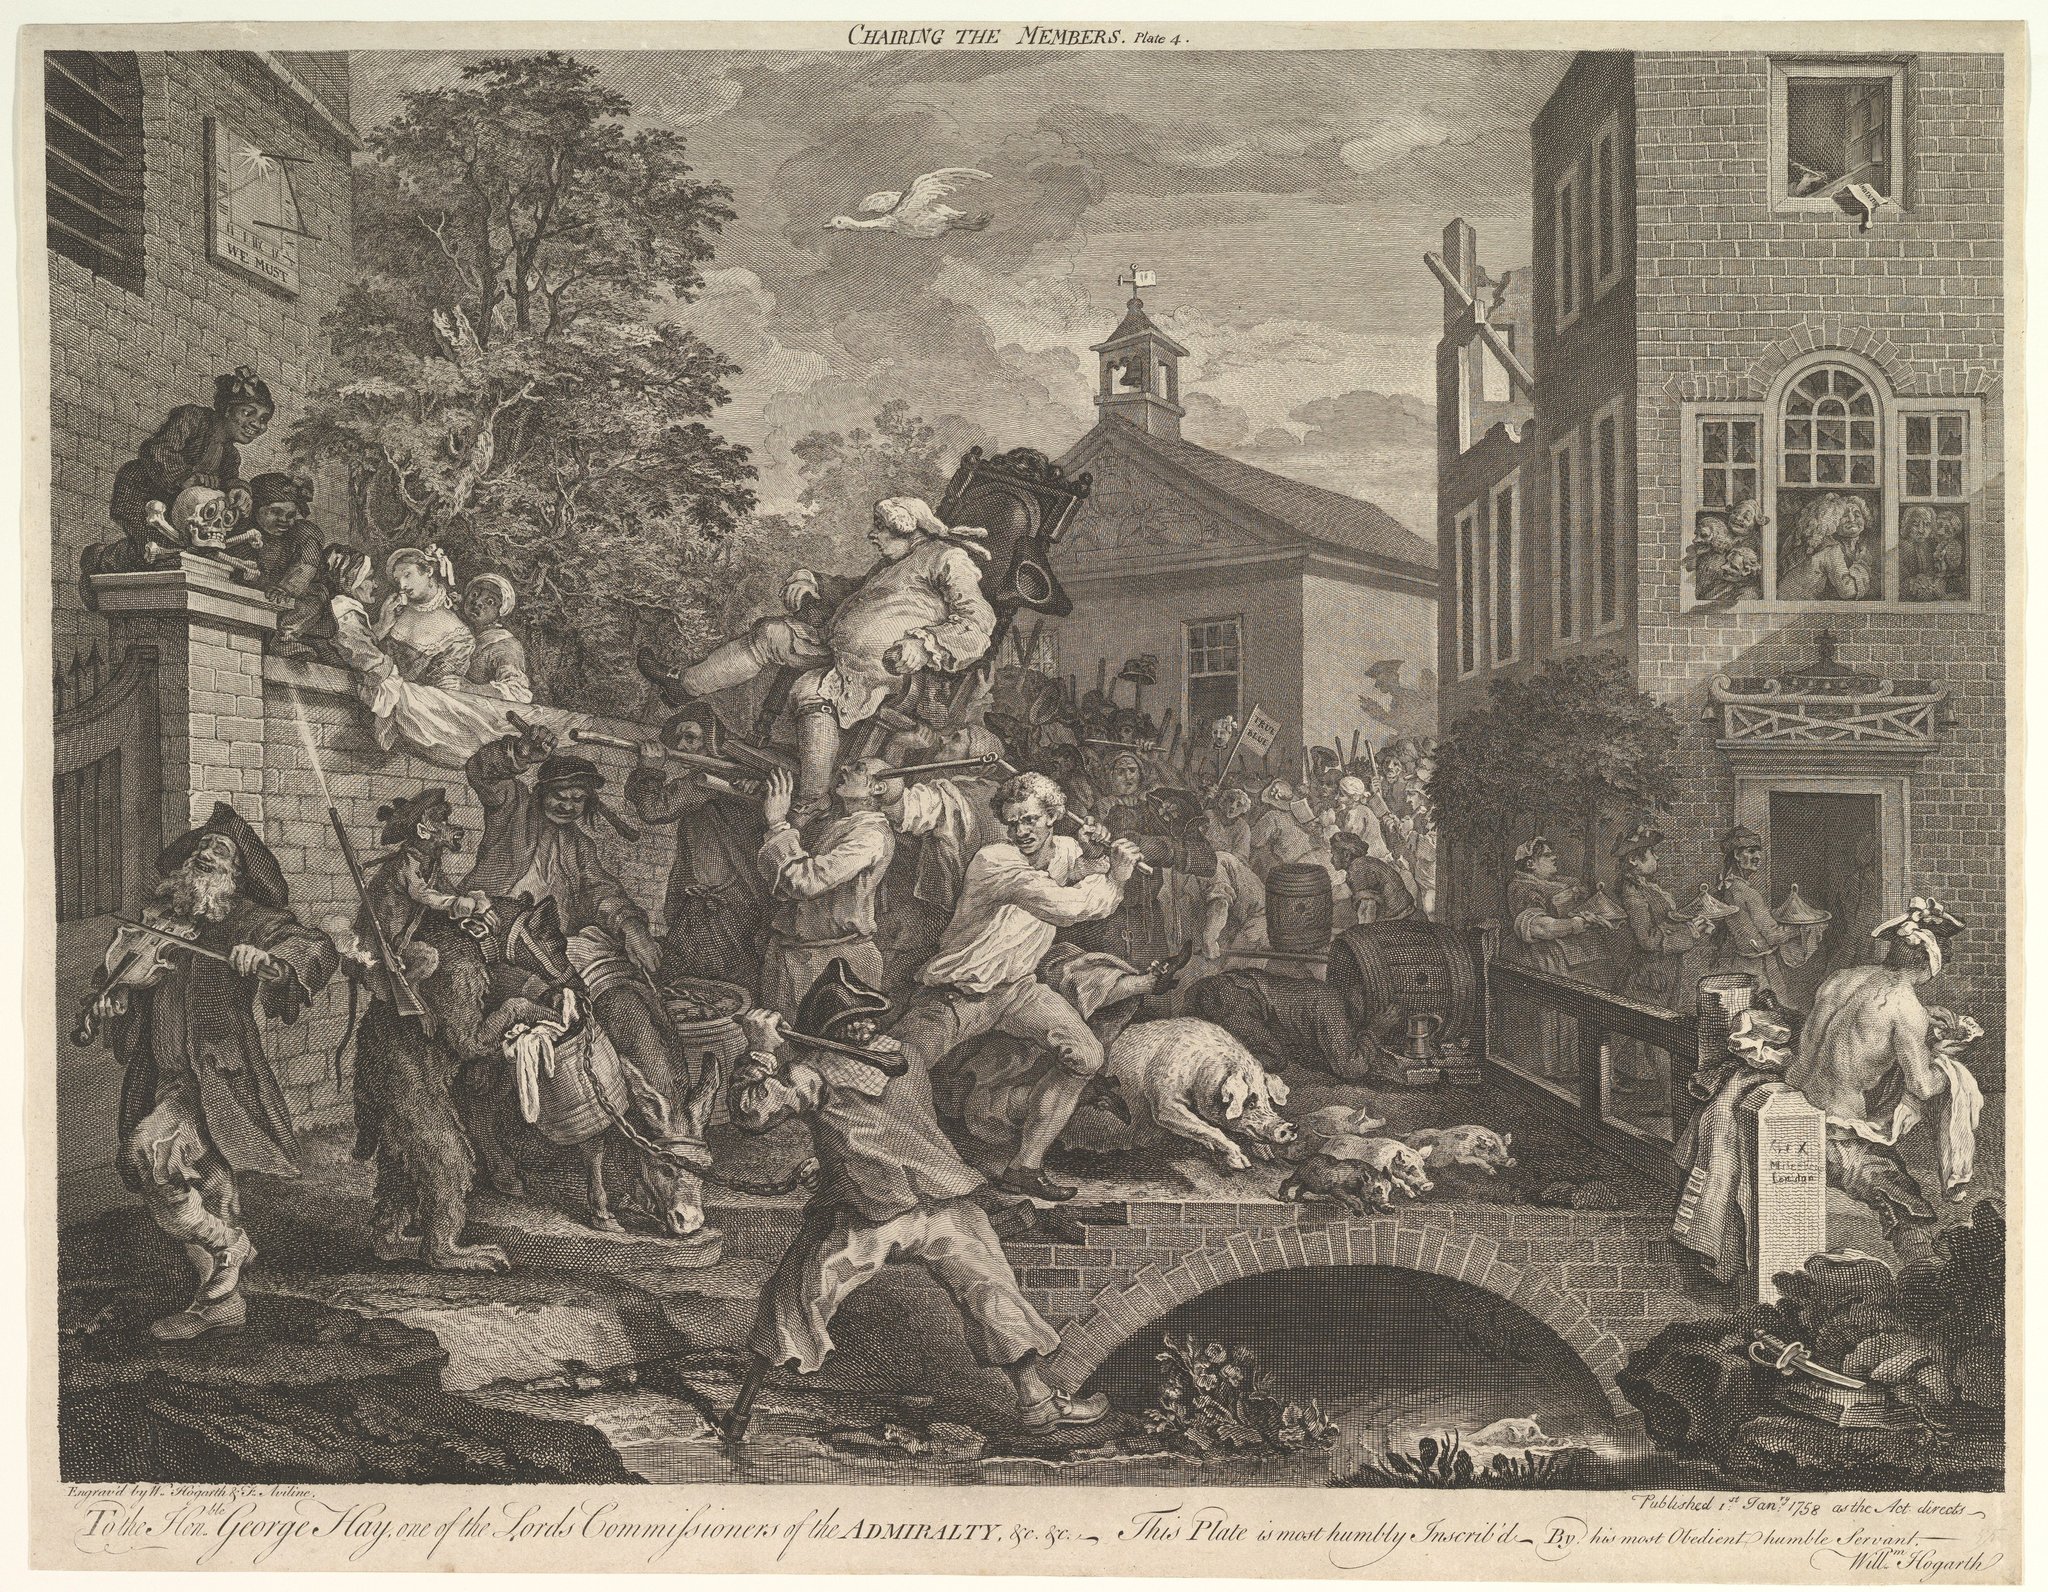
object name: print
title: Chairing the Members, Plate IV: Four Prints of an Election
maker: william hogarth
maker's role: artist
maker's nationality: british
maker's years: 1697-1764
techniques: engraving, etching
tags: pigs,crowd